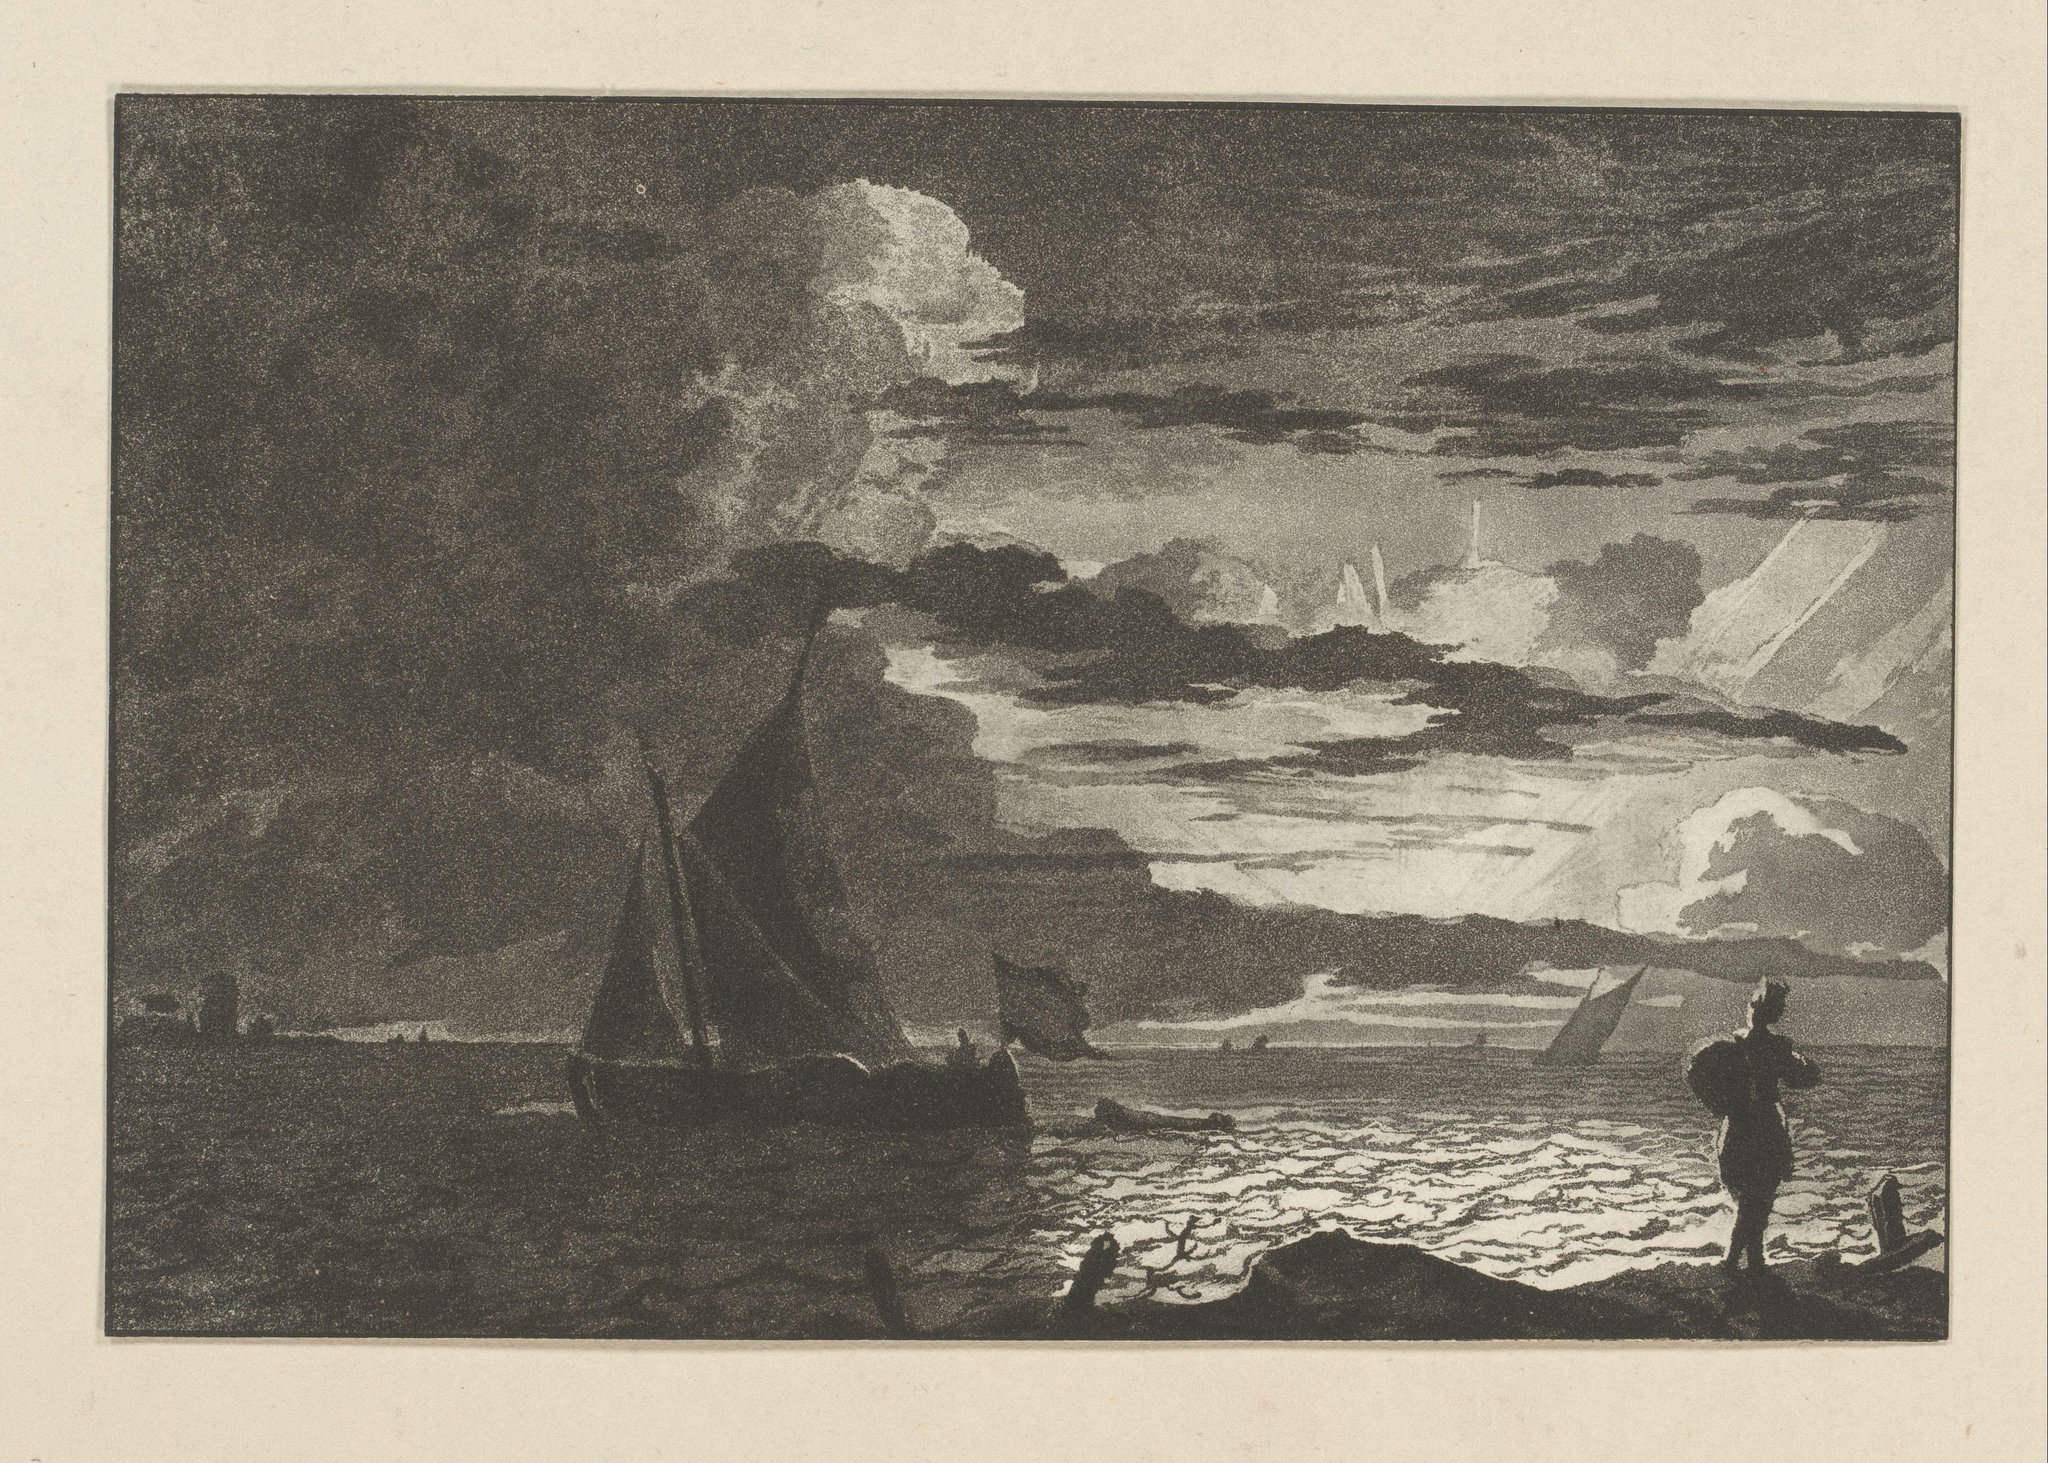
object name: print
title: Man met zak op de schouder bij zonsopgang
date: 1779-1781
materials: paper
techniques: transfer, print drawing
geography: amsterdam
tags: sailing-ship, sailing-boat, sunrise, carrying something on the head or on the shoulders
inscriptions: collector's mark: ‘RIJKS / MUSM’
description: Rechts op de voorgrond een man met een zak op de schouder kijkend naar de schepen en de zonsopgang. De prent ligt los in een album, zie blad 32.